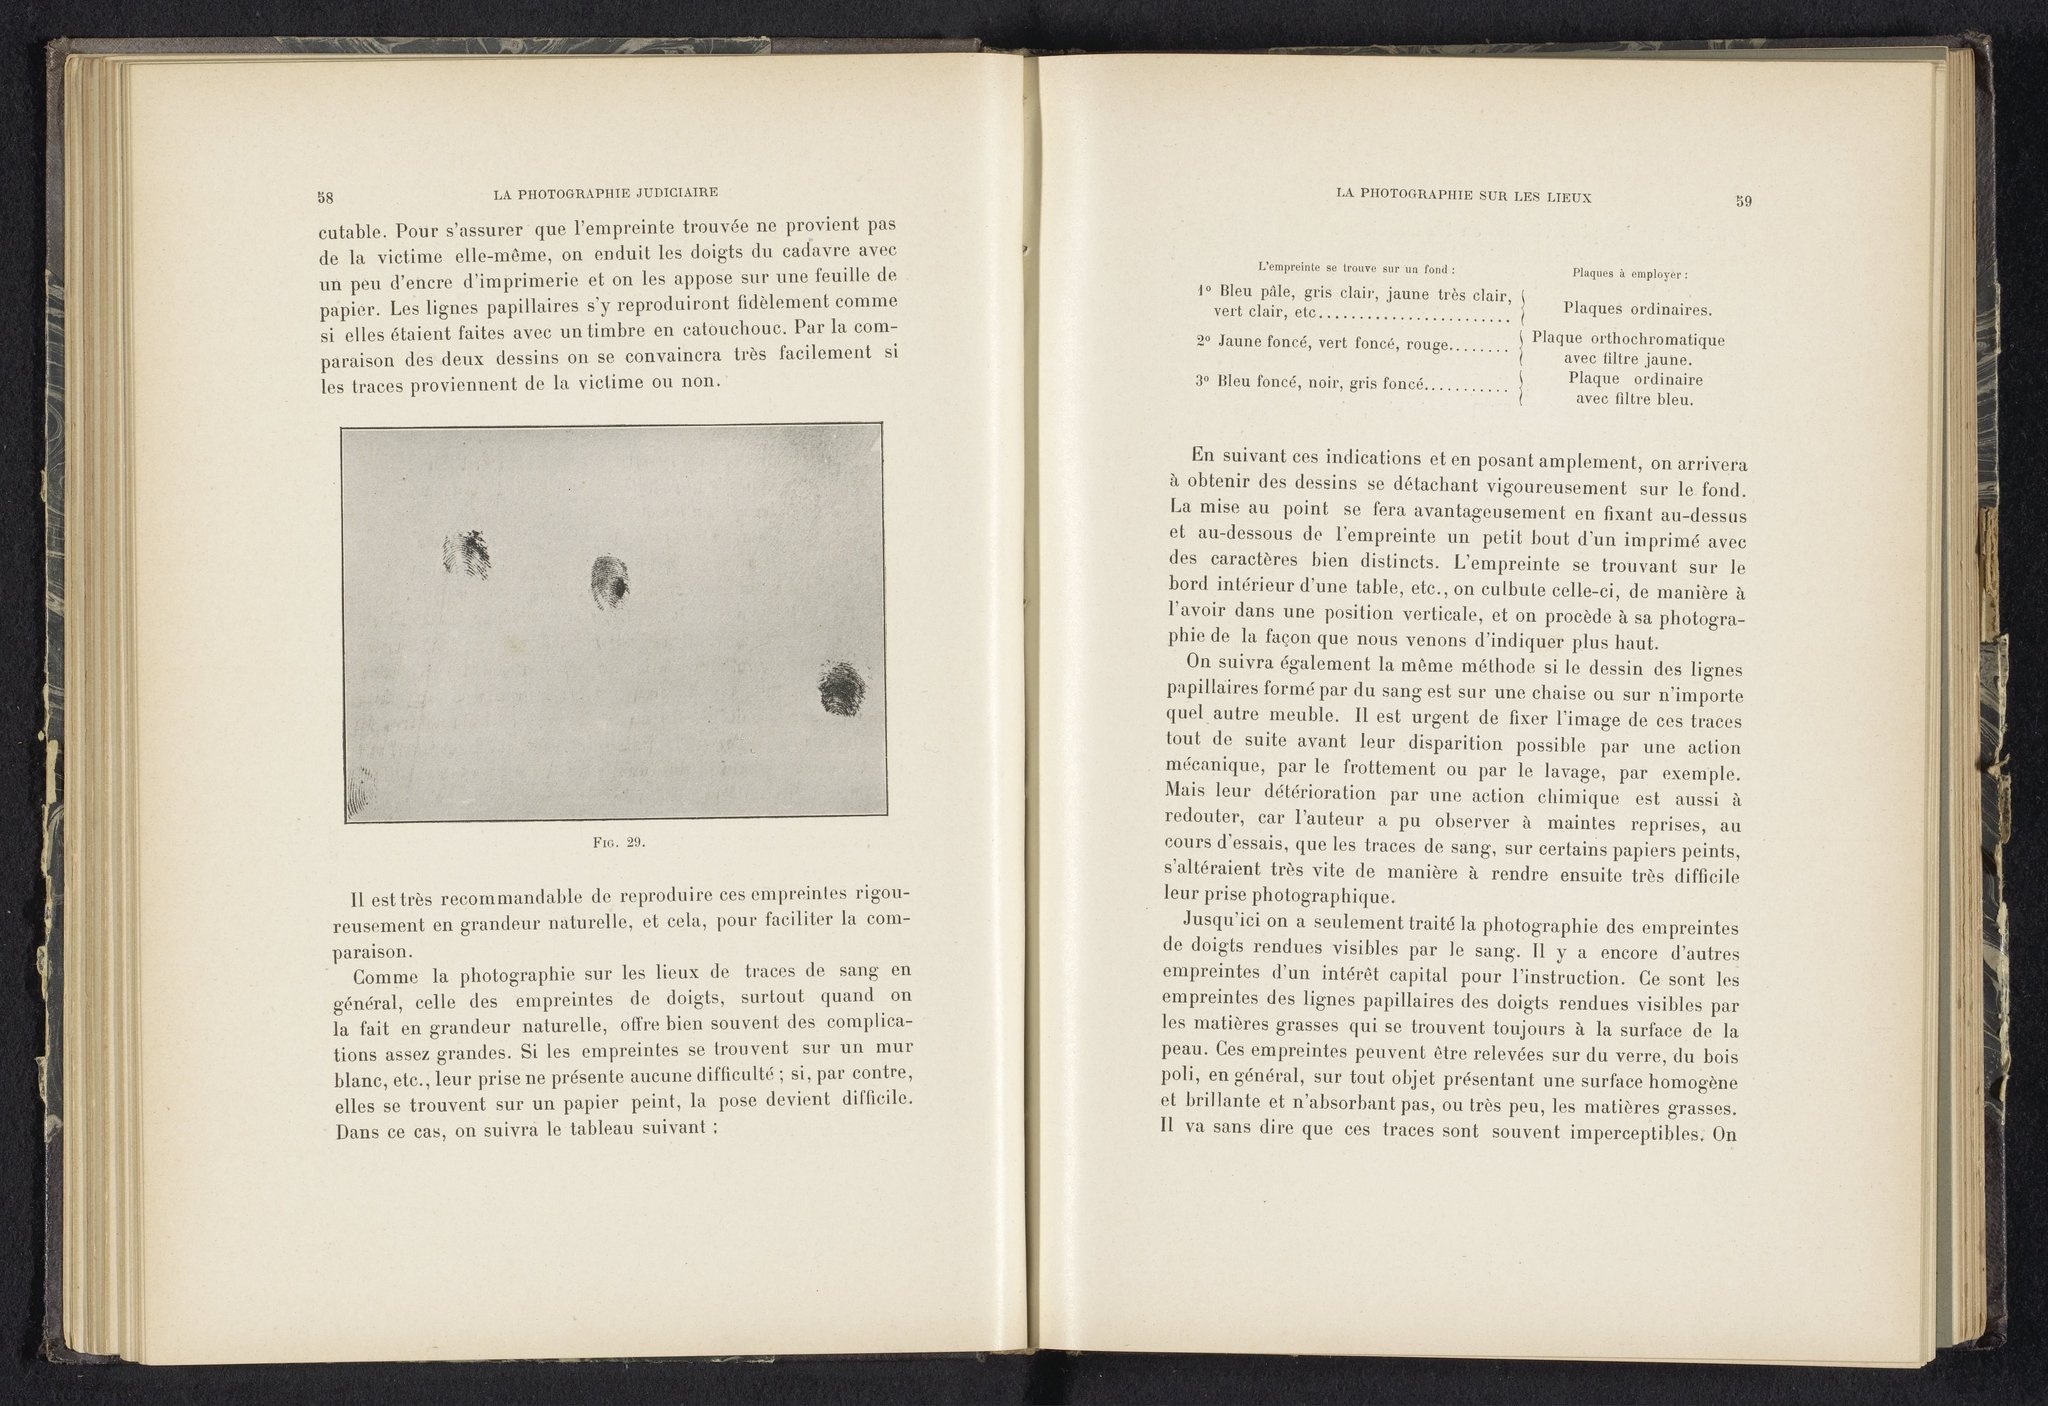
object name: photomechanical print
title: Vier vingerafdrukken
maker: Anonymous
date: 1893-1903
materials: paper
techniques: autotype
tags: finger-prints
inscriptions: number: ‘Fig. 29.’